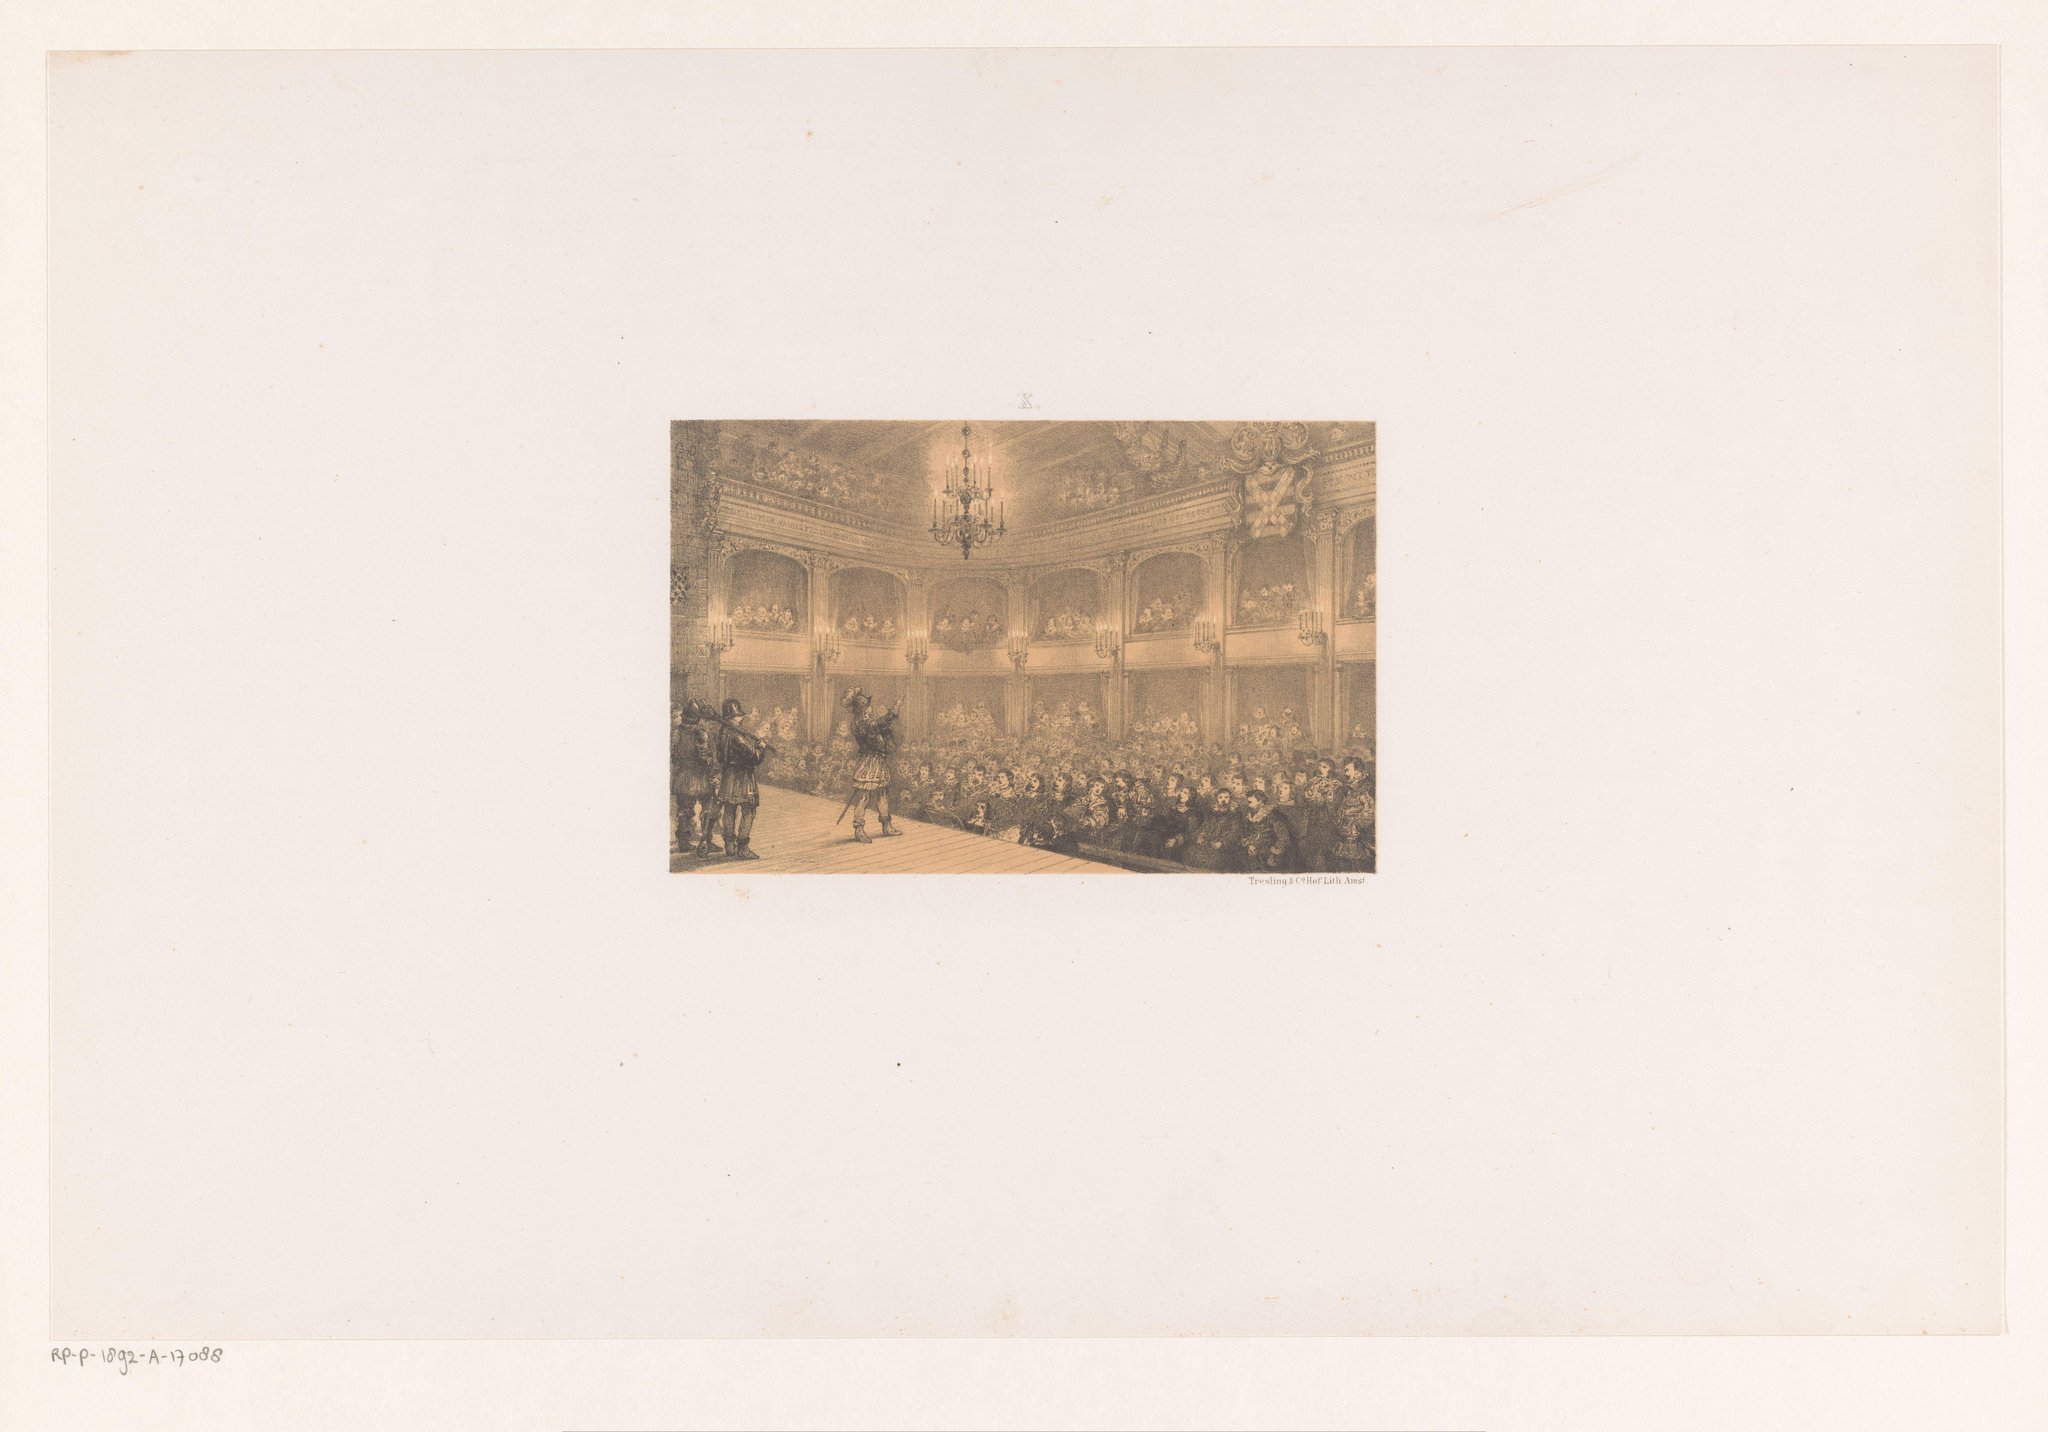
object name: print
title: De eerste vertooning van Gijsbrecht van Aemstel. De inwijding van den Schouwburg, op den 3n Januarij 1638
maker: johan conrad greive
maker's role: draughtsman, painter, print maker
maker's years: 1837-1891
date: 1876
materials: paper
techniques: tone lithography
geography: amsterdam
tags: theatre, theatrical performance, boxes, loges ~ theatre, etc., actor (on the stage)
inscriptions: collector's mark: Lugt 2228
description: Zicht vanaf het toneel naar het publiek, de zaal en de loges. Op het toneel staan enkele figuren in ridderkostuums.